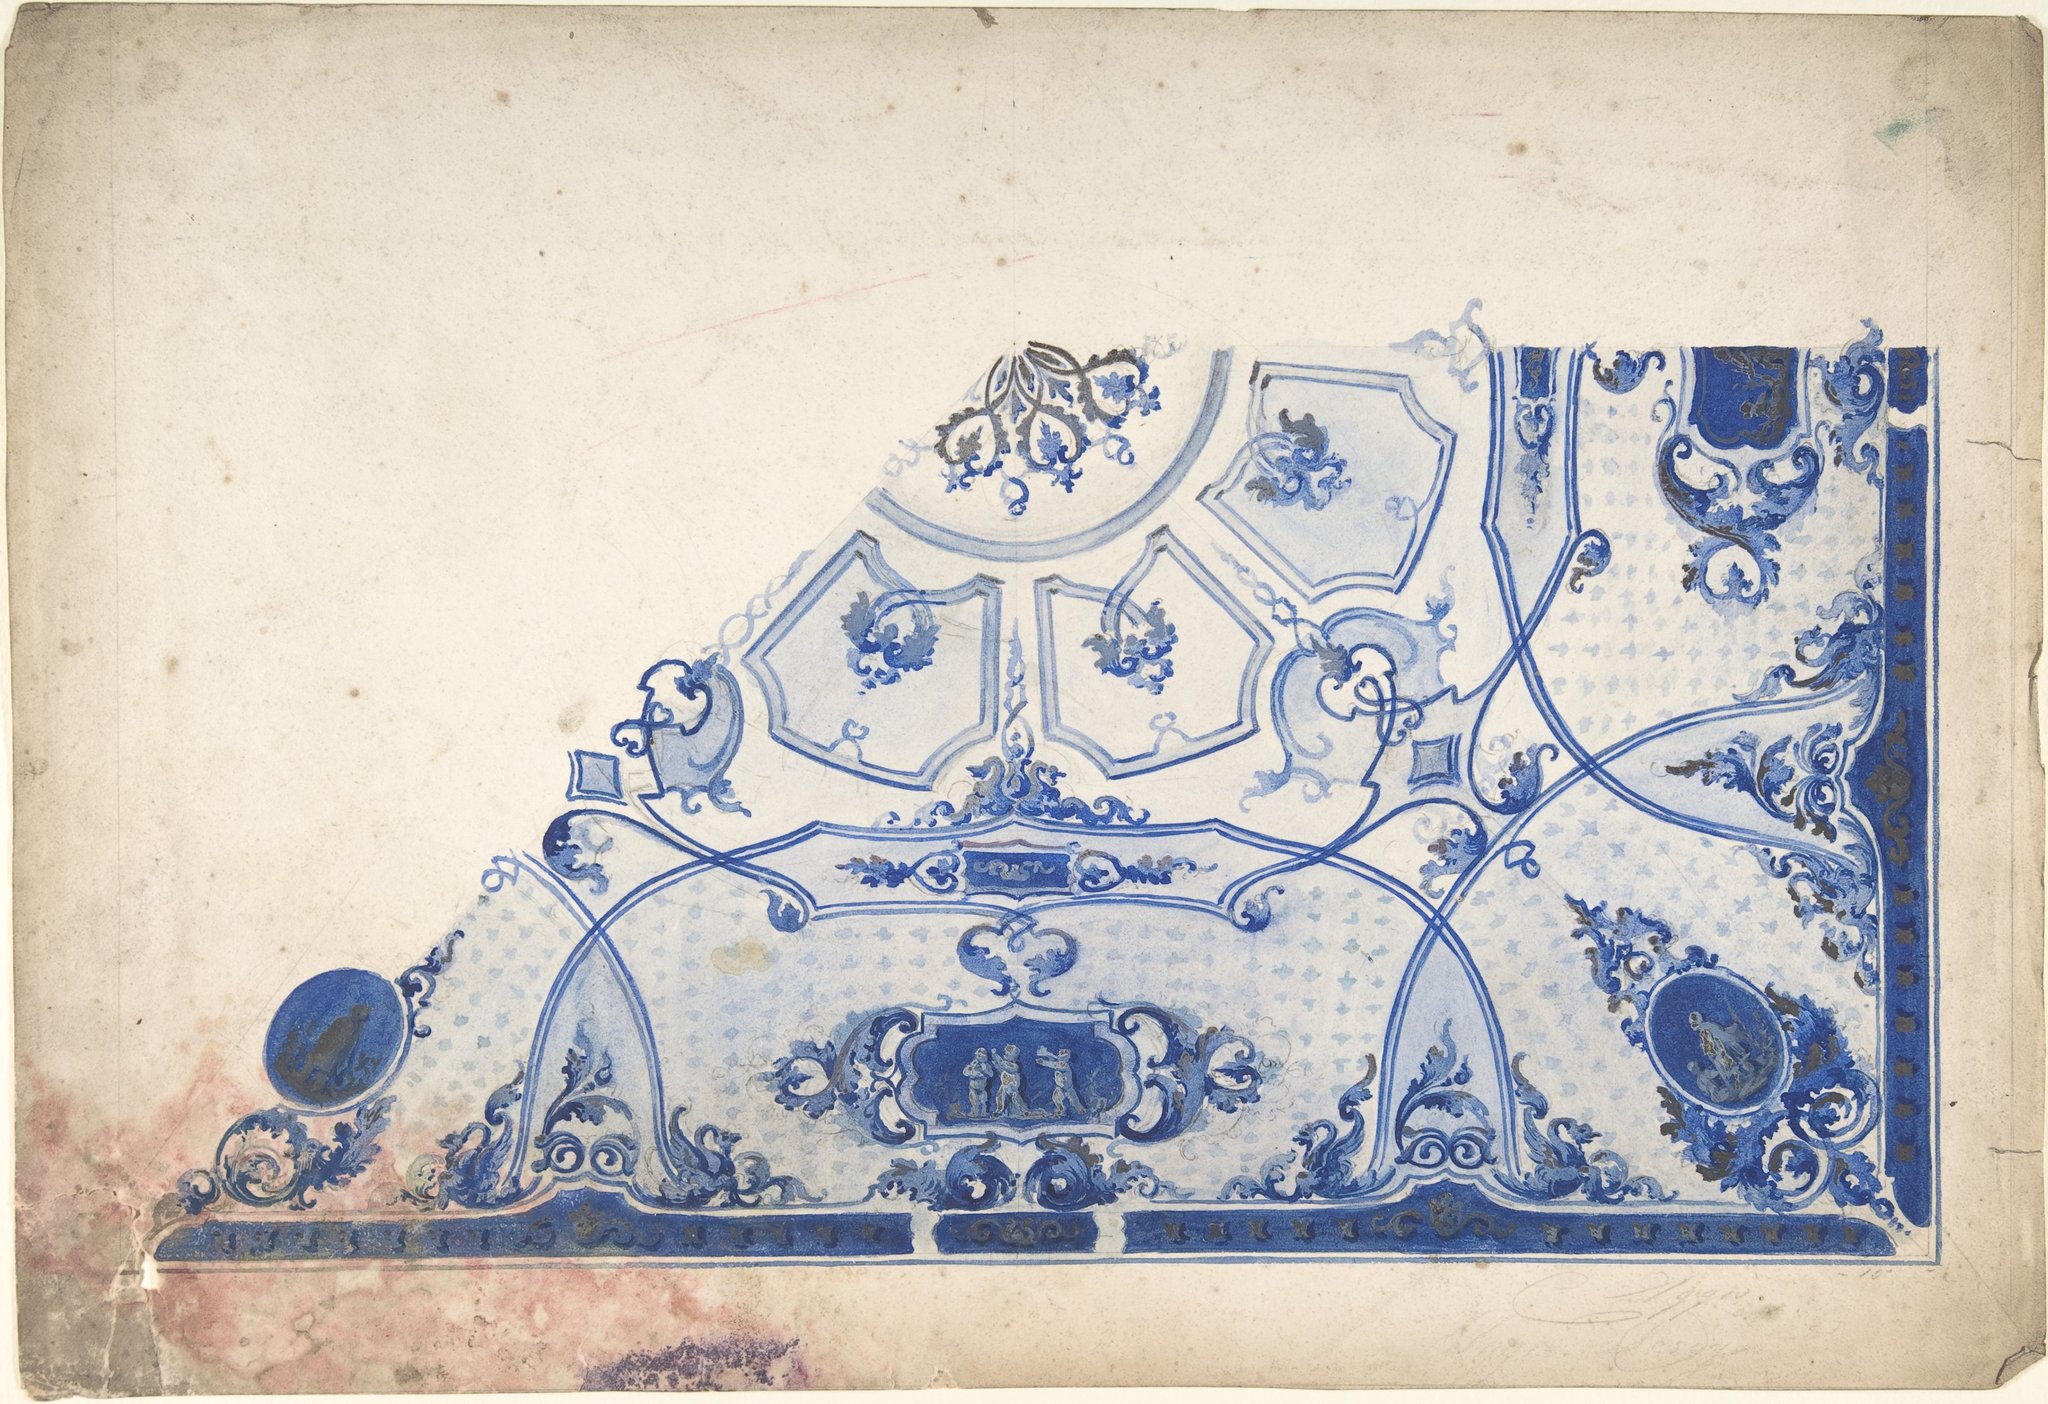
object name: drawing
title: Design for a Painted Ceiling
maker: anonymous, italian, 19th century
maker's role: artist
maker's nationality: italian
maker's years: 1800-1900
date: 1800-1900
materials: watercolor